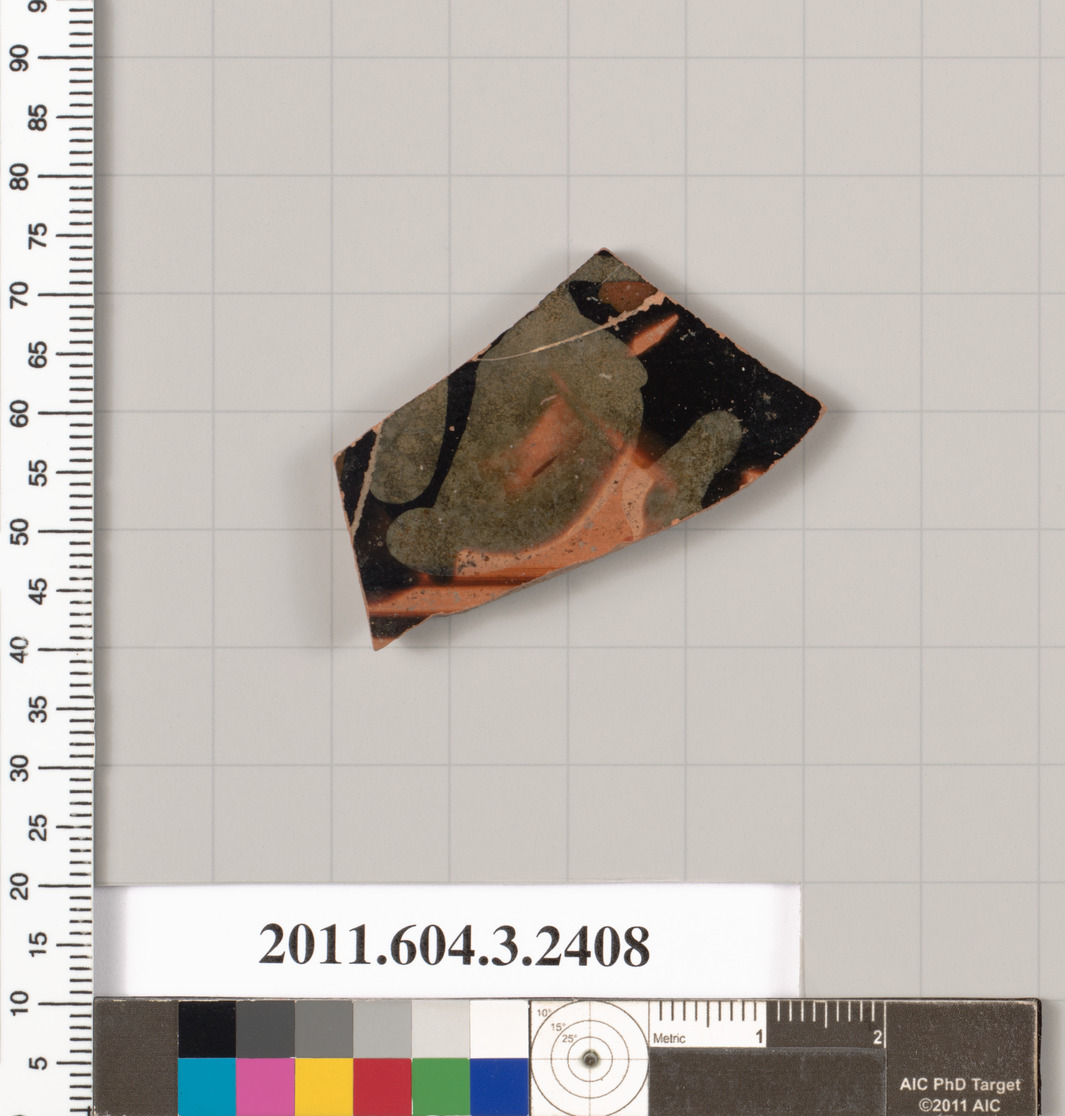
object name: kylix fragment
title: Terracotta fragment of a kylix: eye-cup (drinking cup)?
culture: greek, attic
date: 534-468 BCE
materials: terracotta